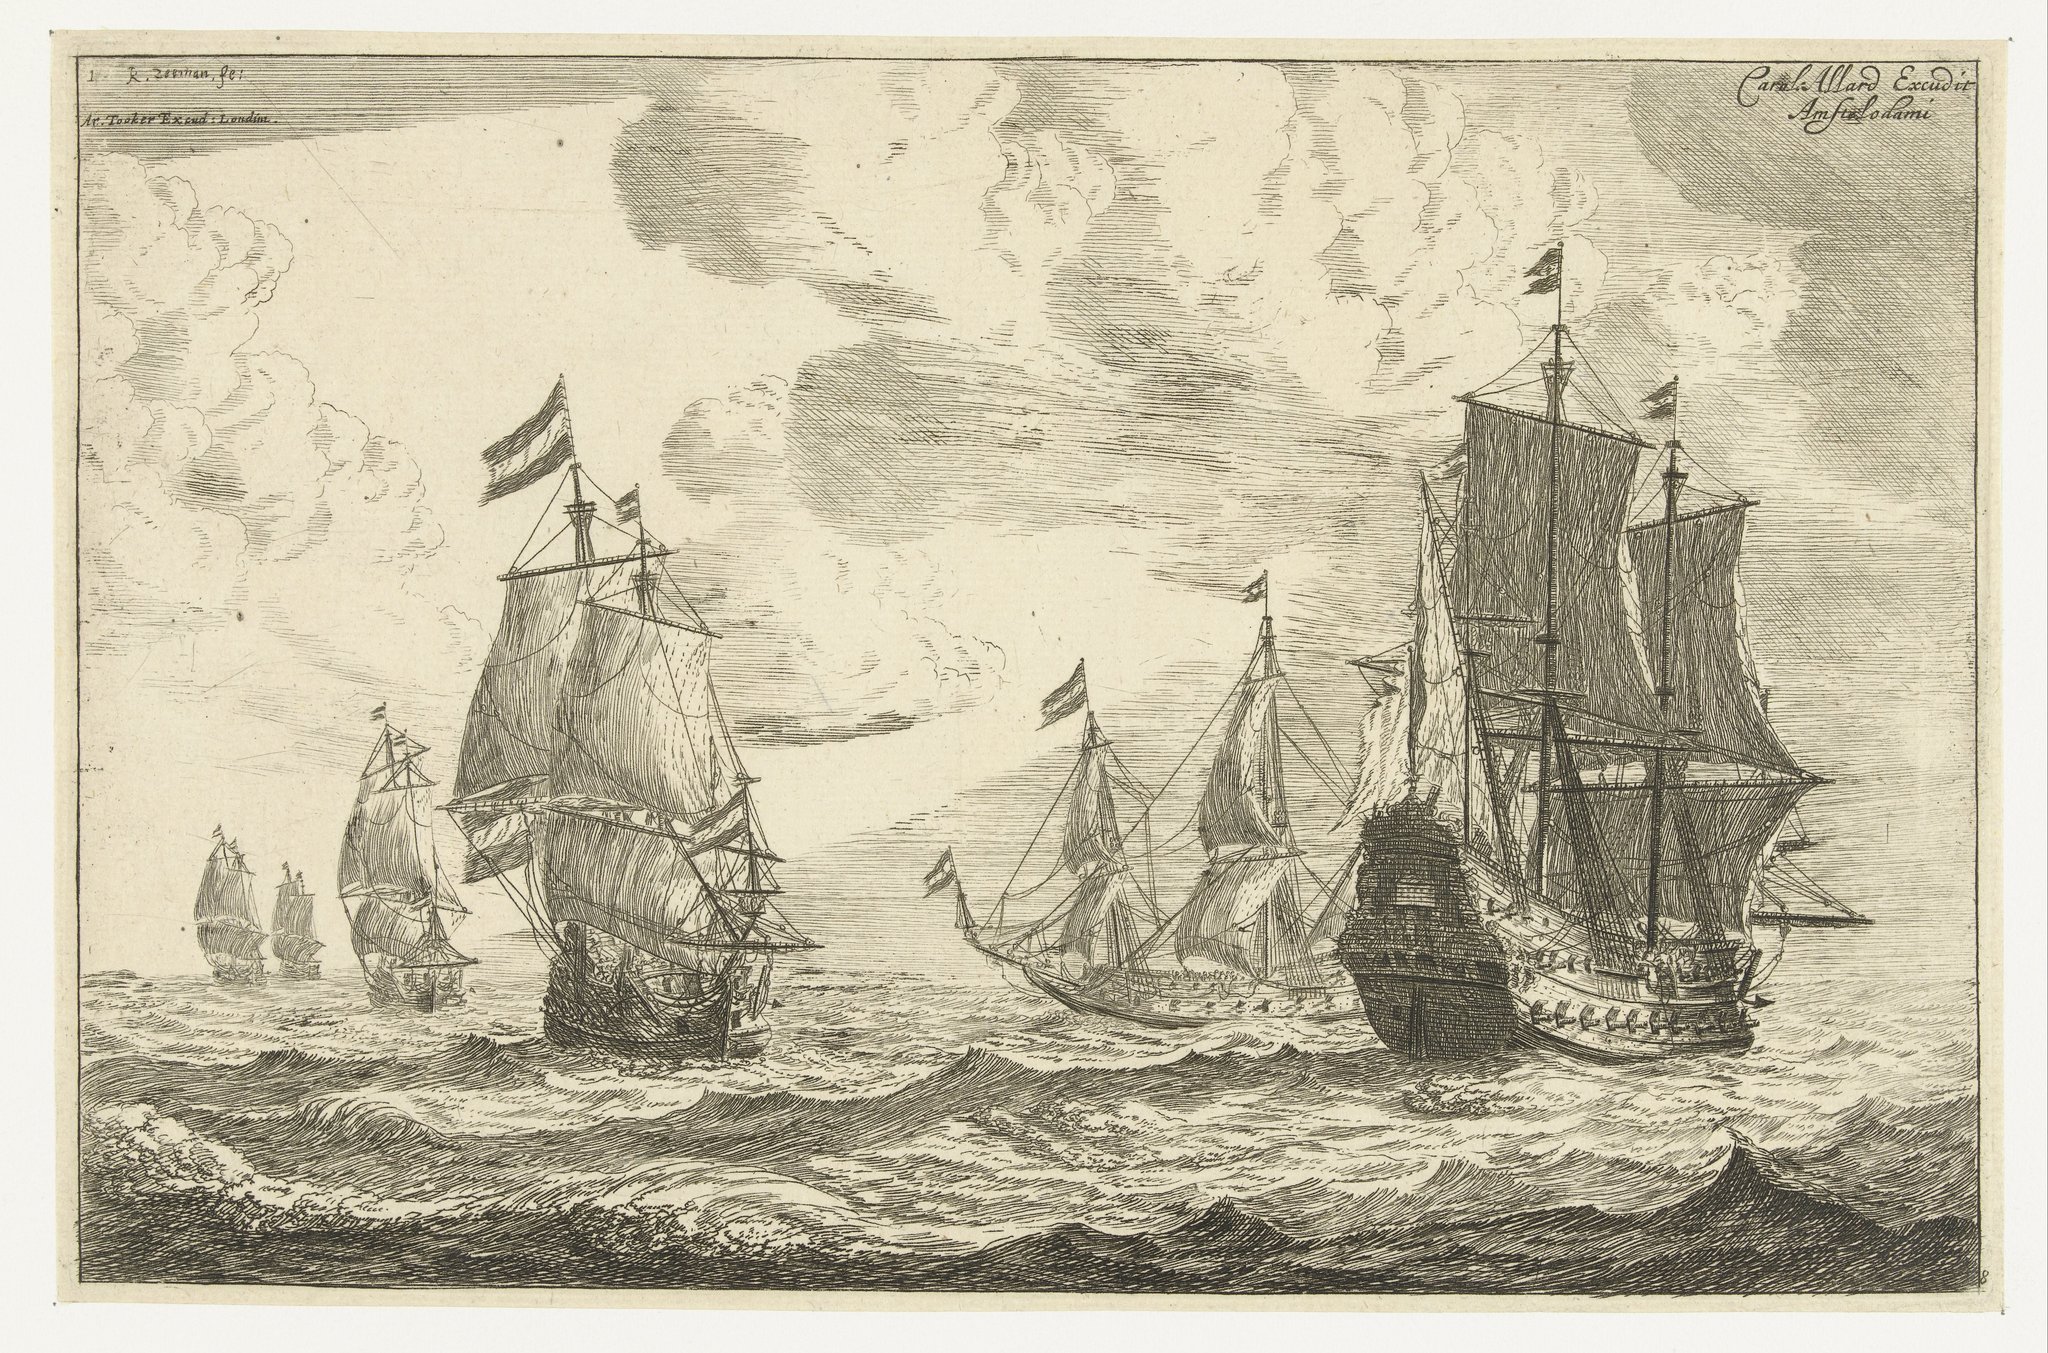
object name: print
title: Dertien scènes met schepen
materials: paper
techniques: etching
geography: amsterdam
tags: sailing-ship, sailing-boat, sailing-ship, sailing-boat (with name)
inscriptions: number: ‘8’, number: ‘1’, collector's mark: Lugt 2228a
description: Open zee met zes zeilschepen. Geheel rechts een pinas, een groot spiegelschip, met een versierd hakkebord.